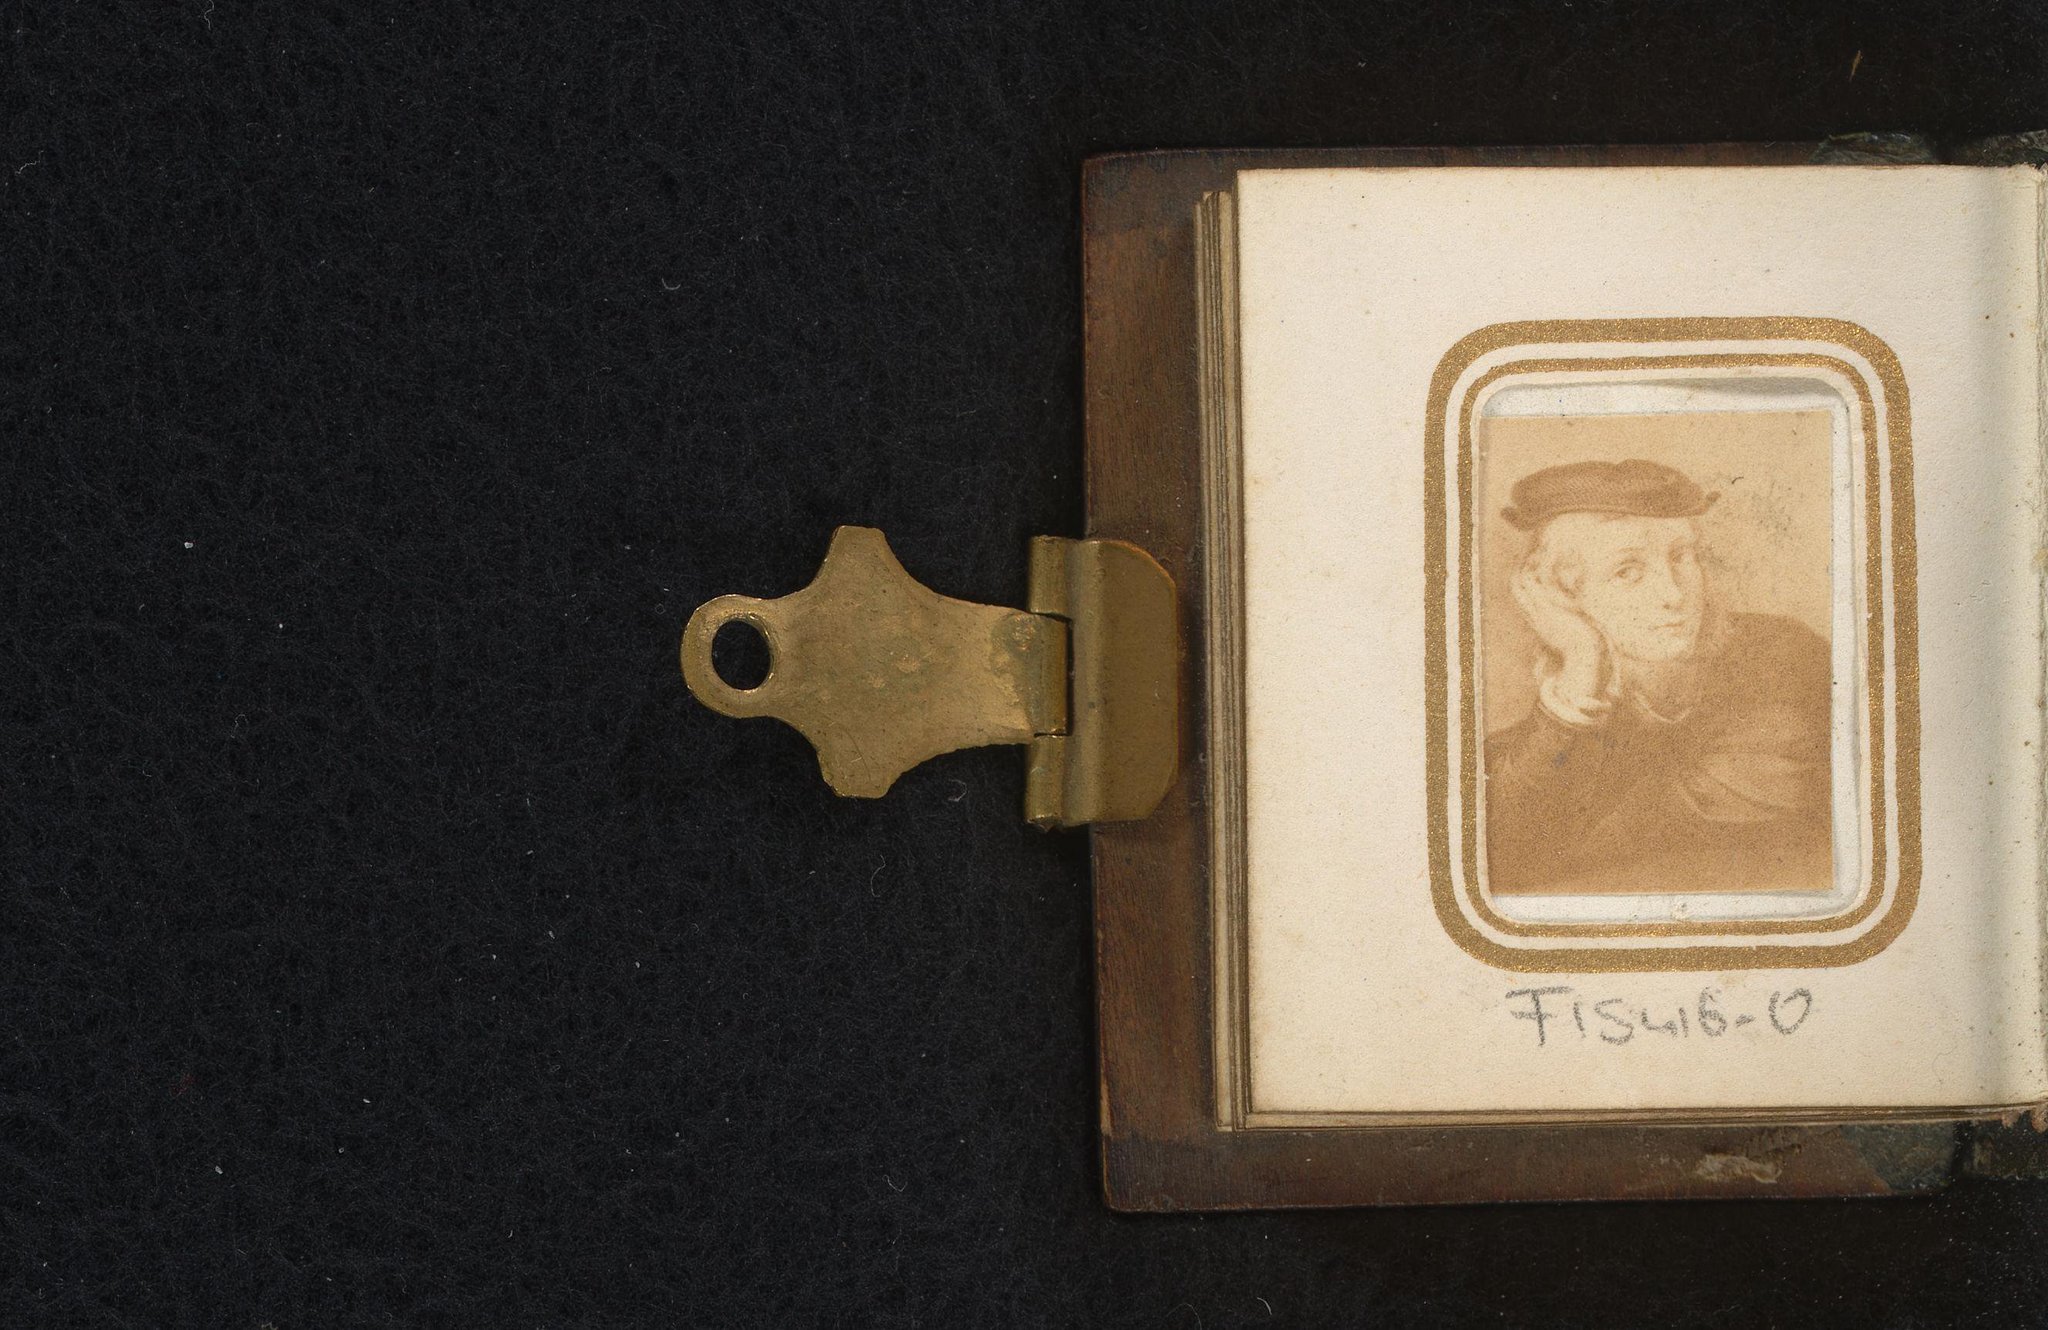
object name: reproduction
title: Fotoreproductie van een portret van een jonge man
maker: Anonymous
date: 1851-1900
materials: paper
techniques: albumen print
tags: youth, adolescent, anonymous historical person portrayed